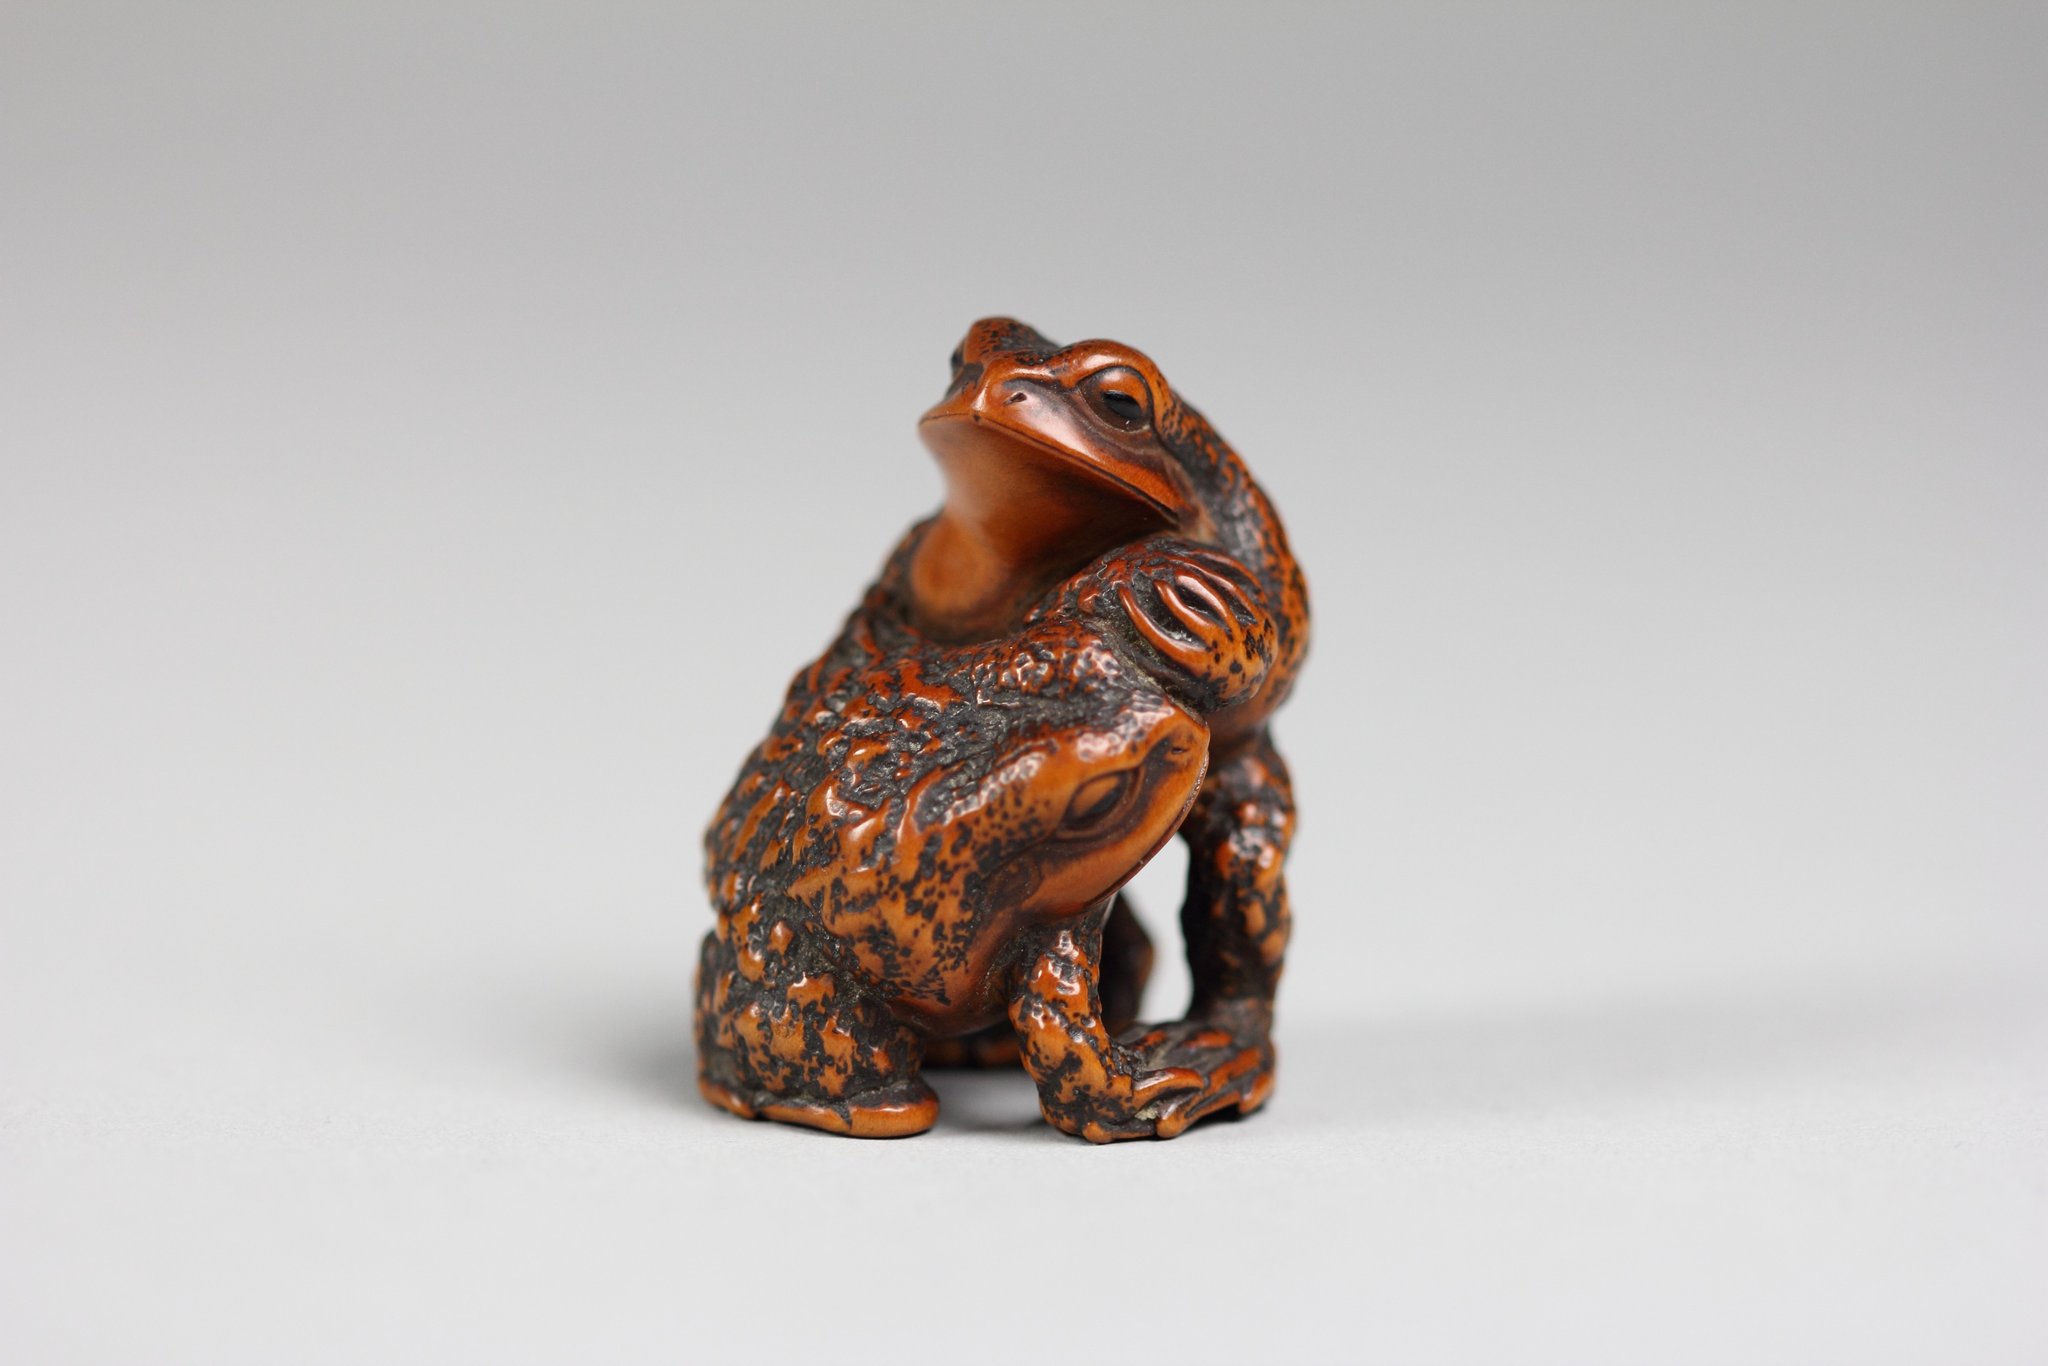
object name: netsuke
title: Netsuke of Two Frogs Wrestling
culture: japanese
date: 1801-1900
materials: wood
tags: frogs